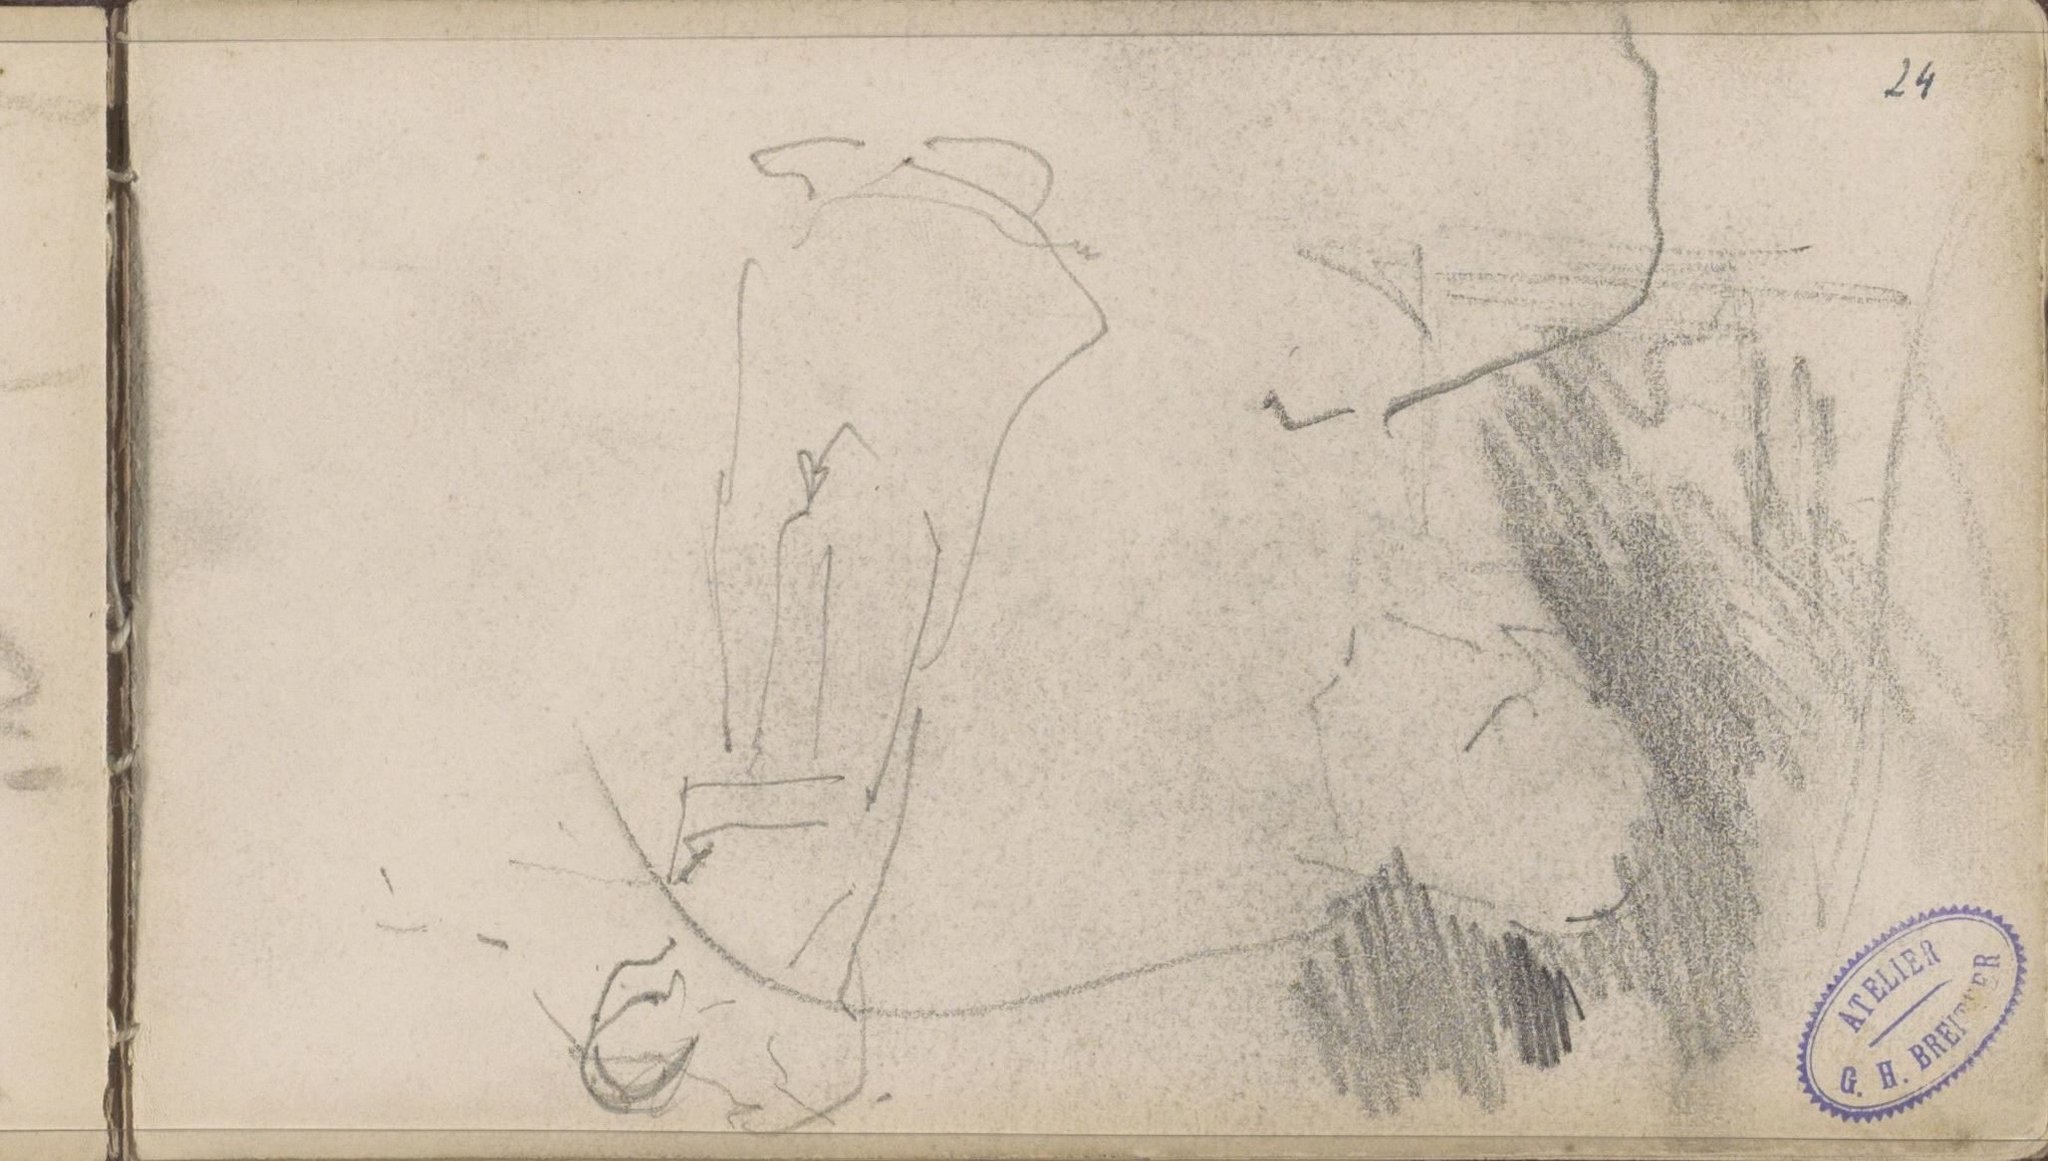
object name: sketchbook leaf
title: Figuurstudies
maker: george hendrik breitner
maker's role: draughtsman, painter, print maker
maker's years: 1857-1923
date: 1880-1882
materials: paper, pencil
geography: the hague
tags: adult woman, adult man, standing figure - aa - female human figure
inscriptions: workshop stamp: Lugt 291d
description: Blad 24 recto uit een schetsboek met 16 bladen.